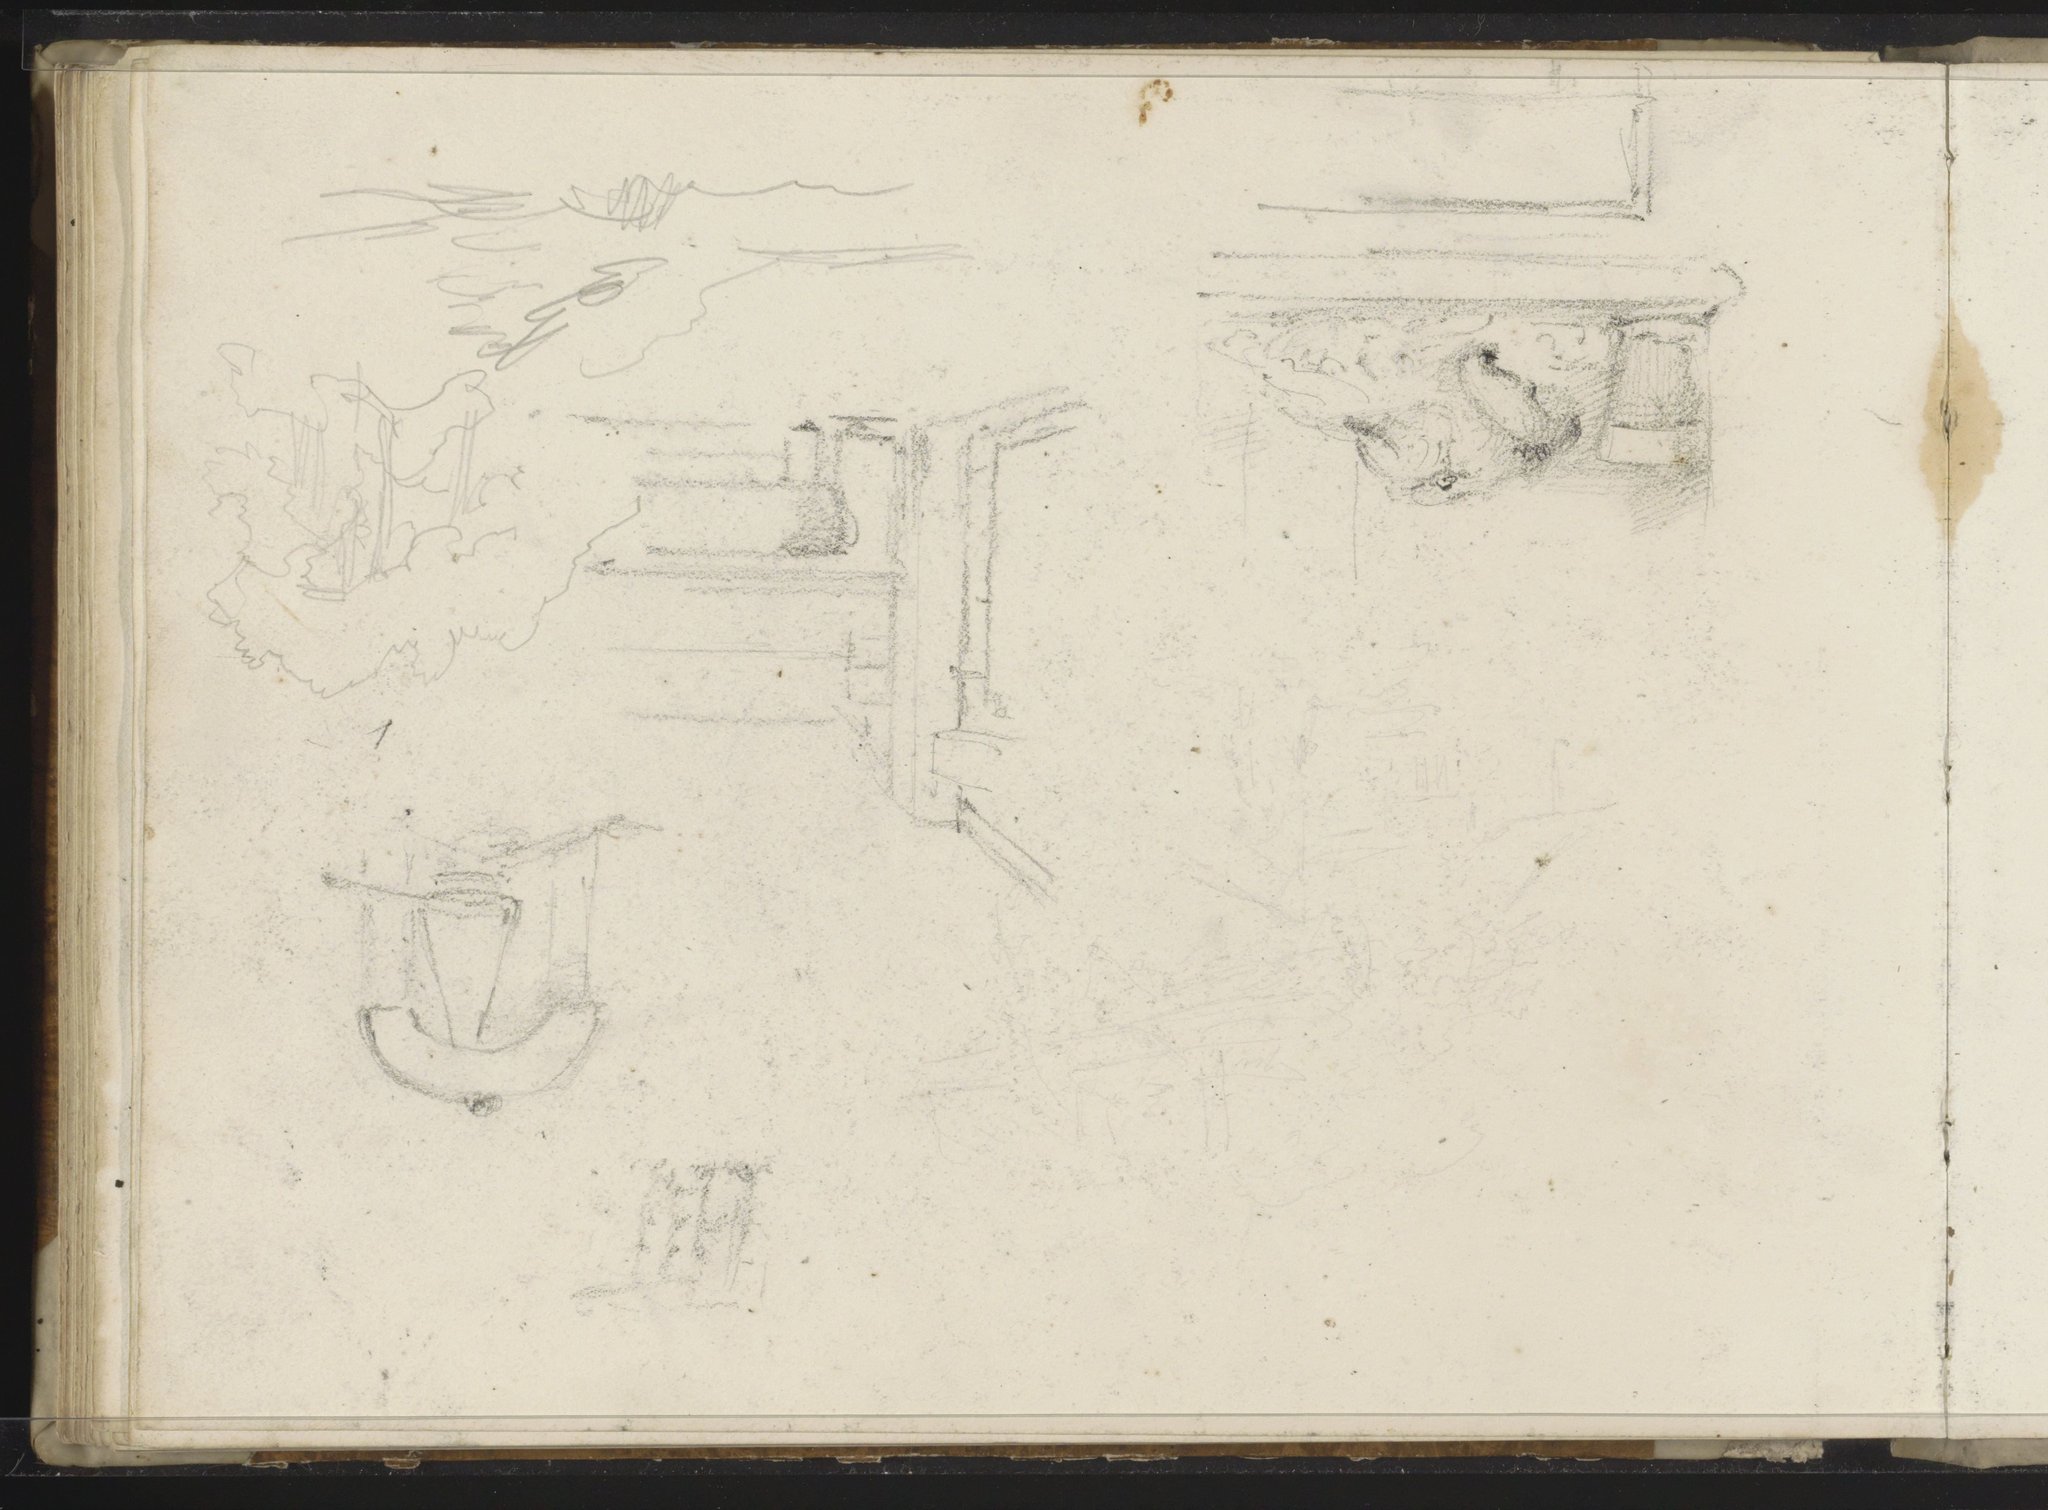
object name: sketchbook leaf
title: Bomen en architectuurdetails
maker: maria vos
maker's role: draughtsman, painter, print maker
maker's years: 1824-1906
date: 1834-1906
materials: paper, pencil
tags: trees, architectural detail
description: Blad 39 verso uit een schetsboek met 39 bladen.